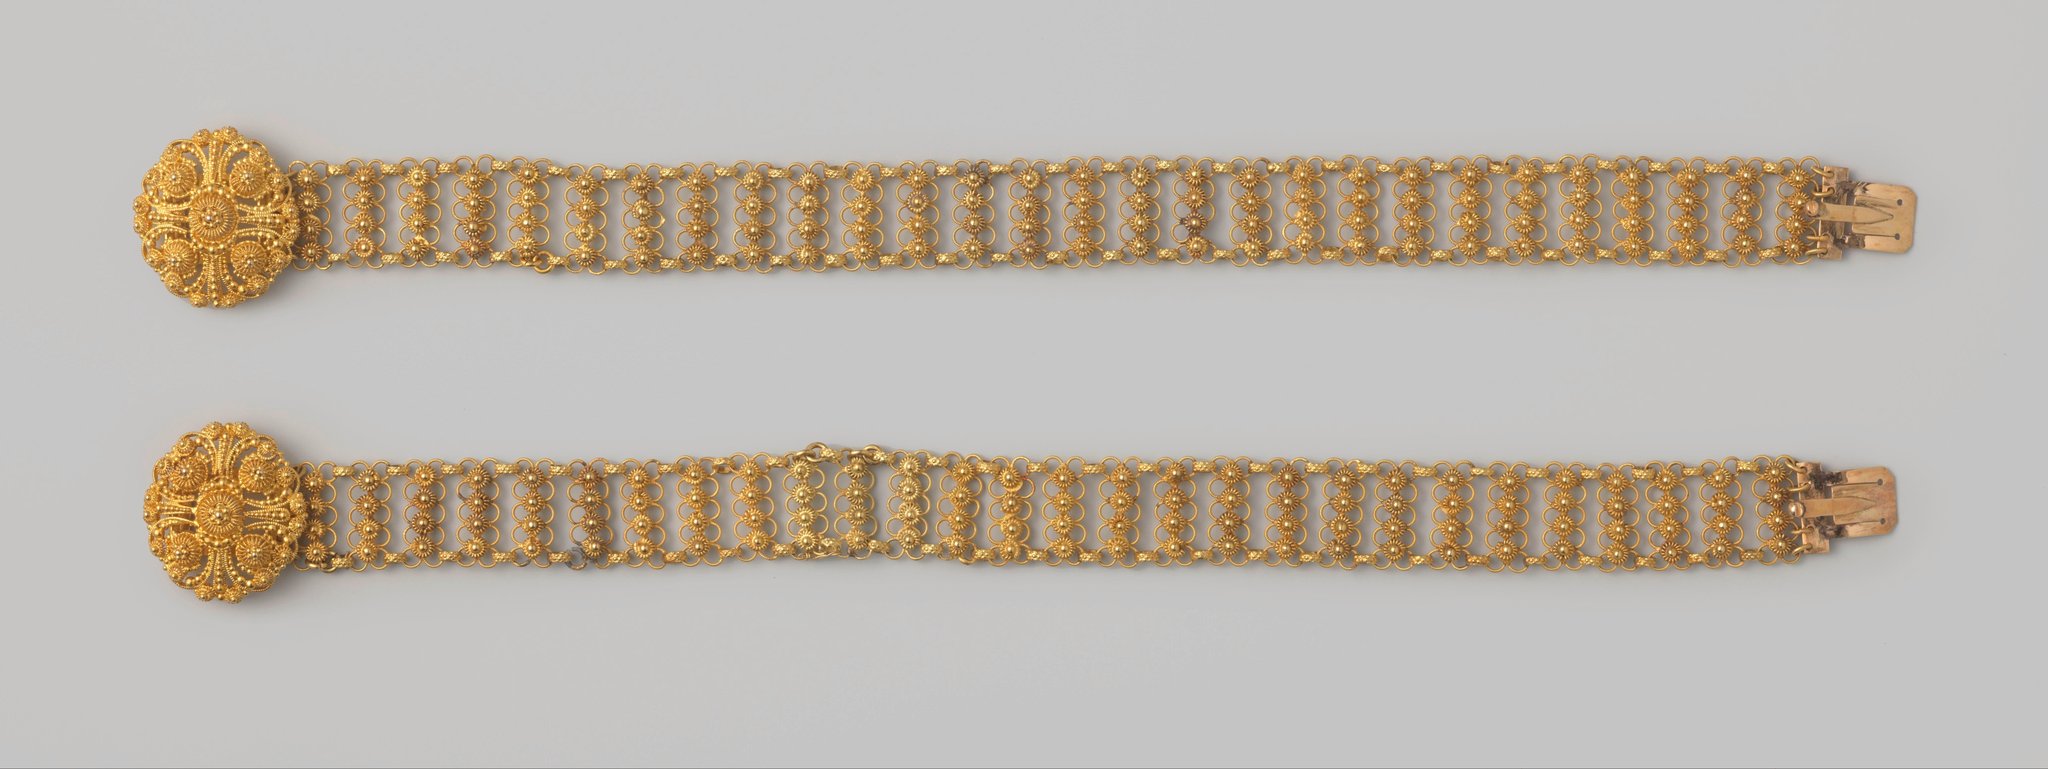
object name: bracelet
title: Twee armbanden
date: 1835-1837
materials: gold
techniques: filigree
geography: amsterdam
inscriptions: alloy mark: ‘leeuwenkop’, maker's mark: ‘W&S’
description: Parure van goud in filigreintechniek, in rood leren foedraal. Bestaande uit: diadeem, halssnoer, twee armbanden en twee oorknoppen. Het foedraal is met witte zijde gevoerd.